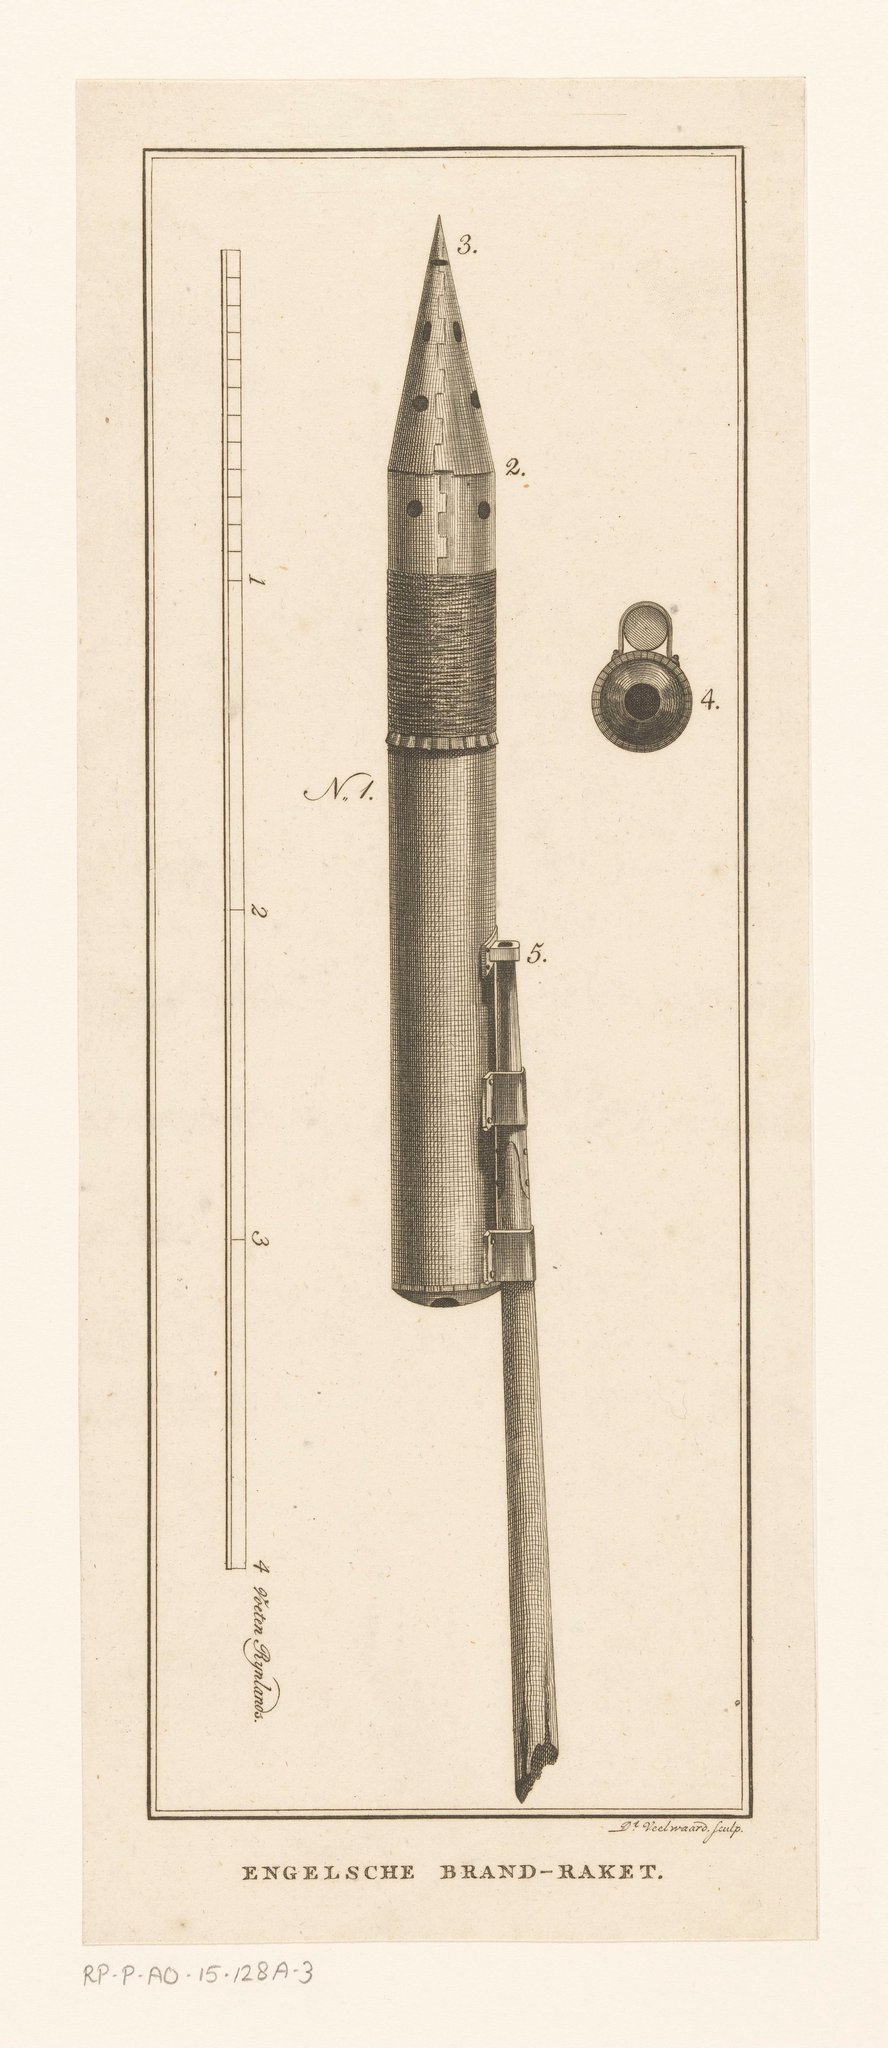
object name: print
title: Engelsche brand-raket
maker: daniël veelwaard (i)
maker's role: print maker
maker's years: 1766-1851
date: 1809-1810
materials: paper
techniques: engraving, etching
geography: amsterdam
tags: bombardment (+ weapons)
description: Congreveraket, zoals mogelijk gebruikt door de Engelsen bij het bombardement van Vlissingen op 13 augustus 1809. Lengteaanzicht en doorsnede van de raket (vuurpijl), de onderdelen genummerd, met een schaalstok: Voeten Rynlands.